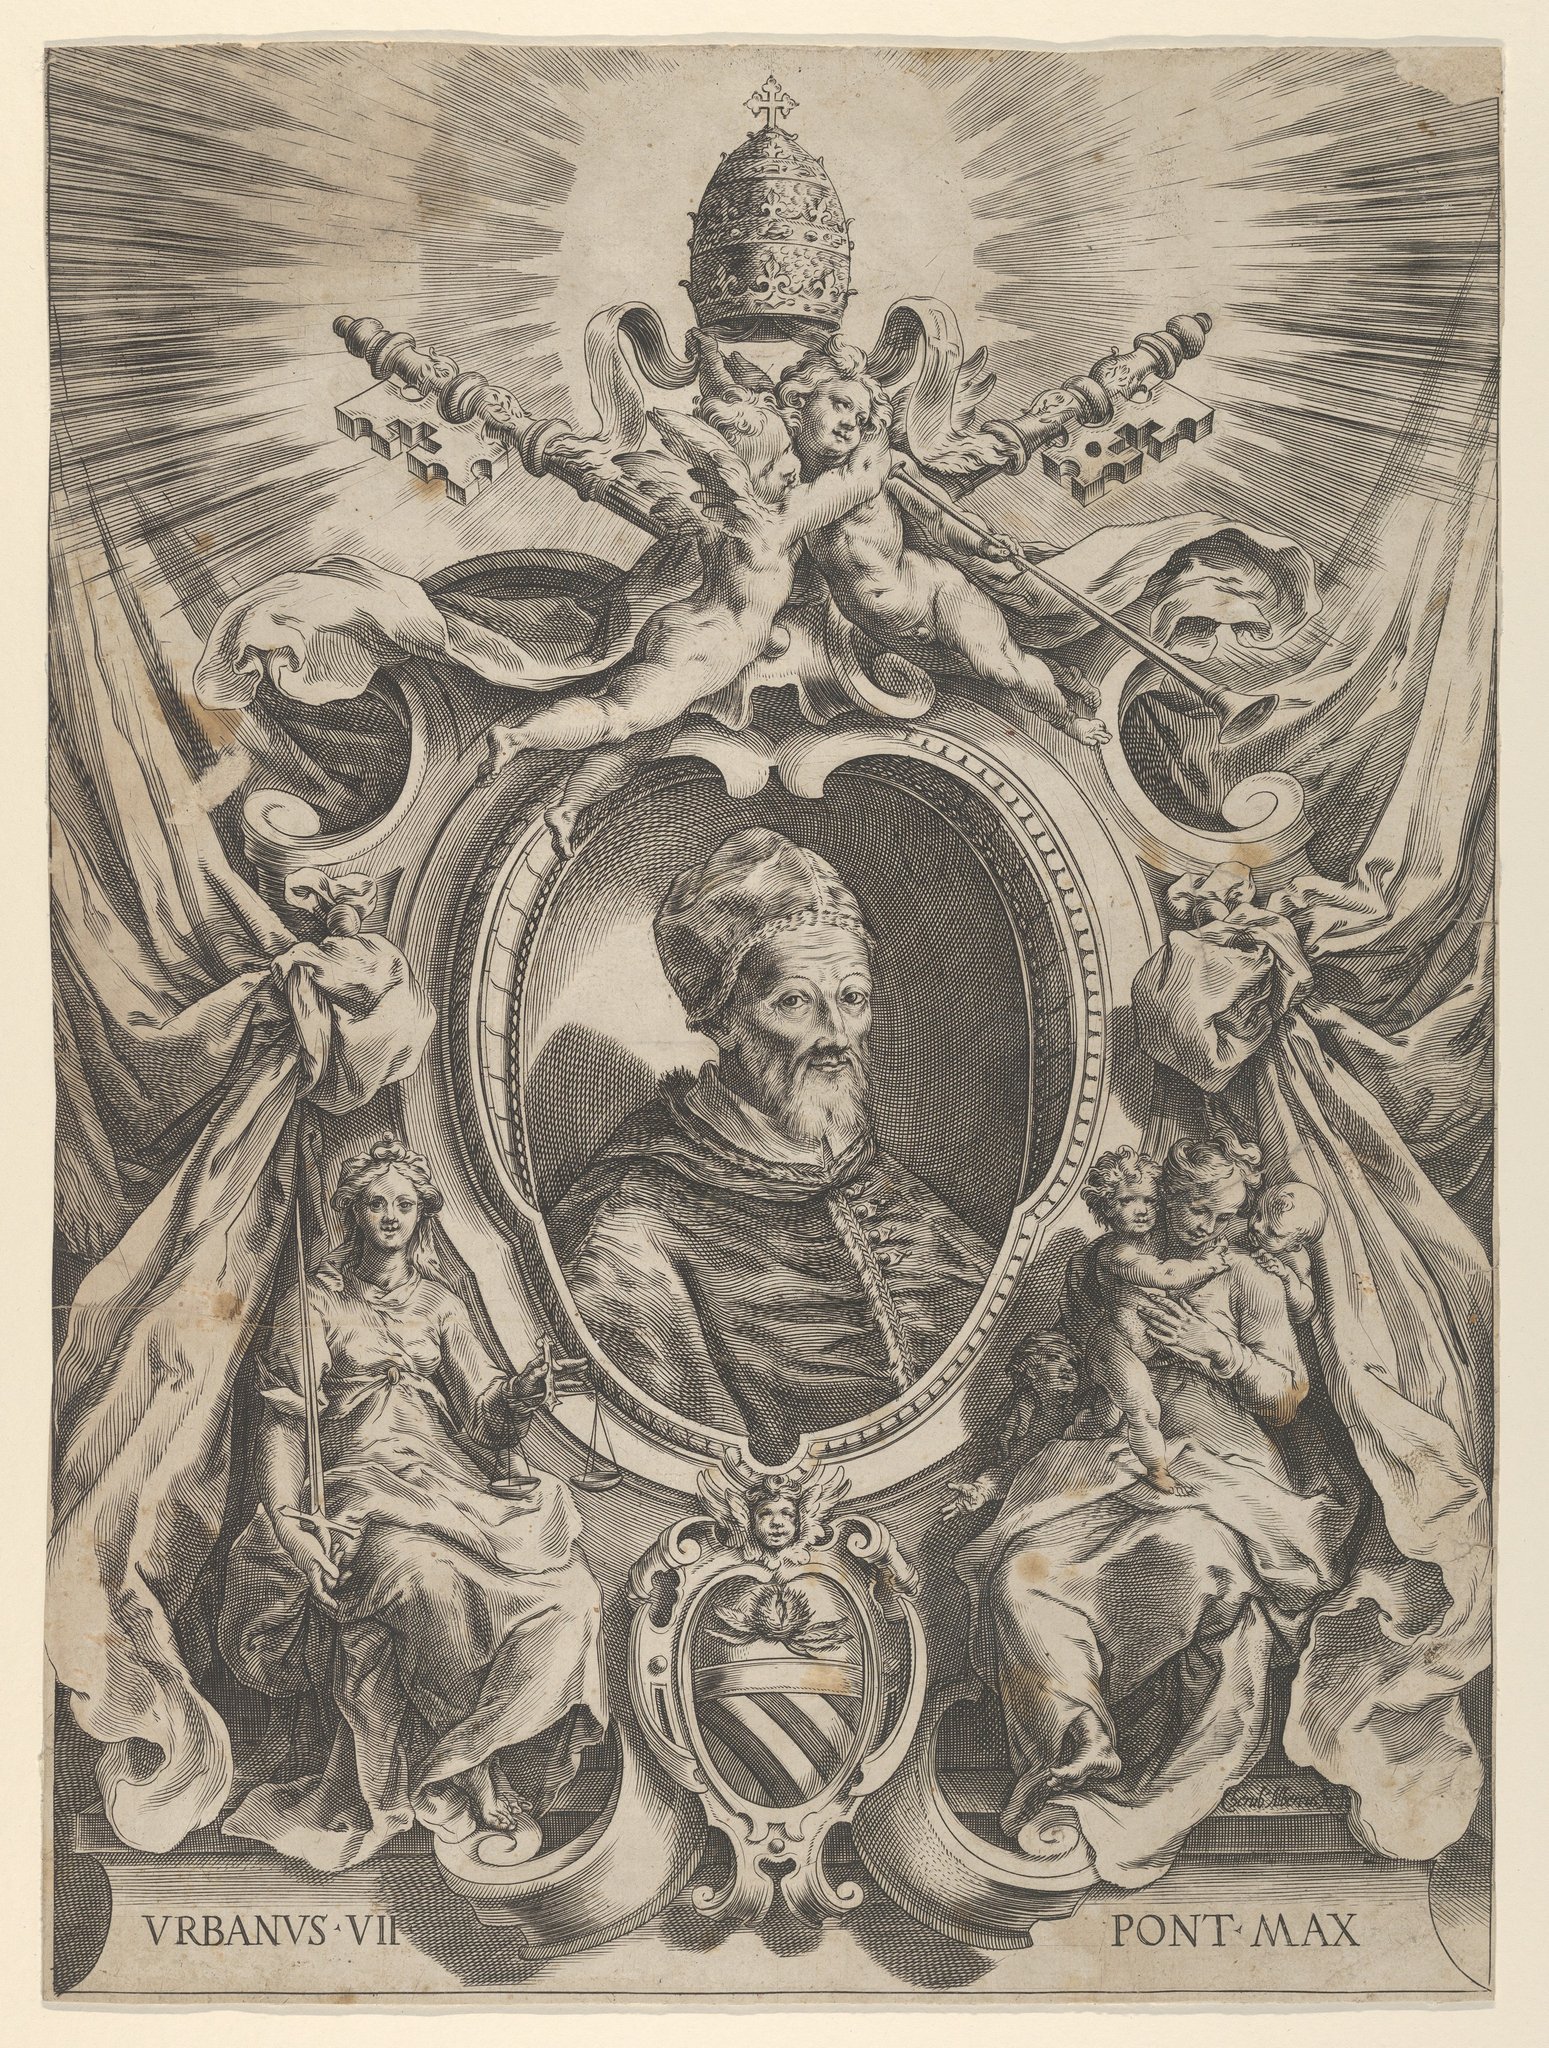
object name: print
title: Portrait of Pope Urban VII in a decorative border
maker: cherubino alberti (zaccaria mattia)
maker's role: artist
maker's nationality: italian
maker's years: 1553-1615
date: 1570-1615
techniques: engraving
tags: cartouches,portraits,women,popes